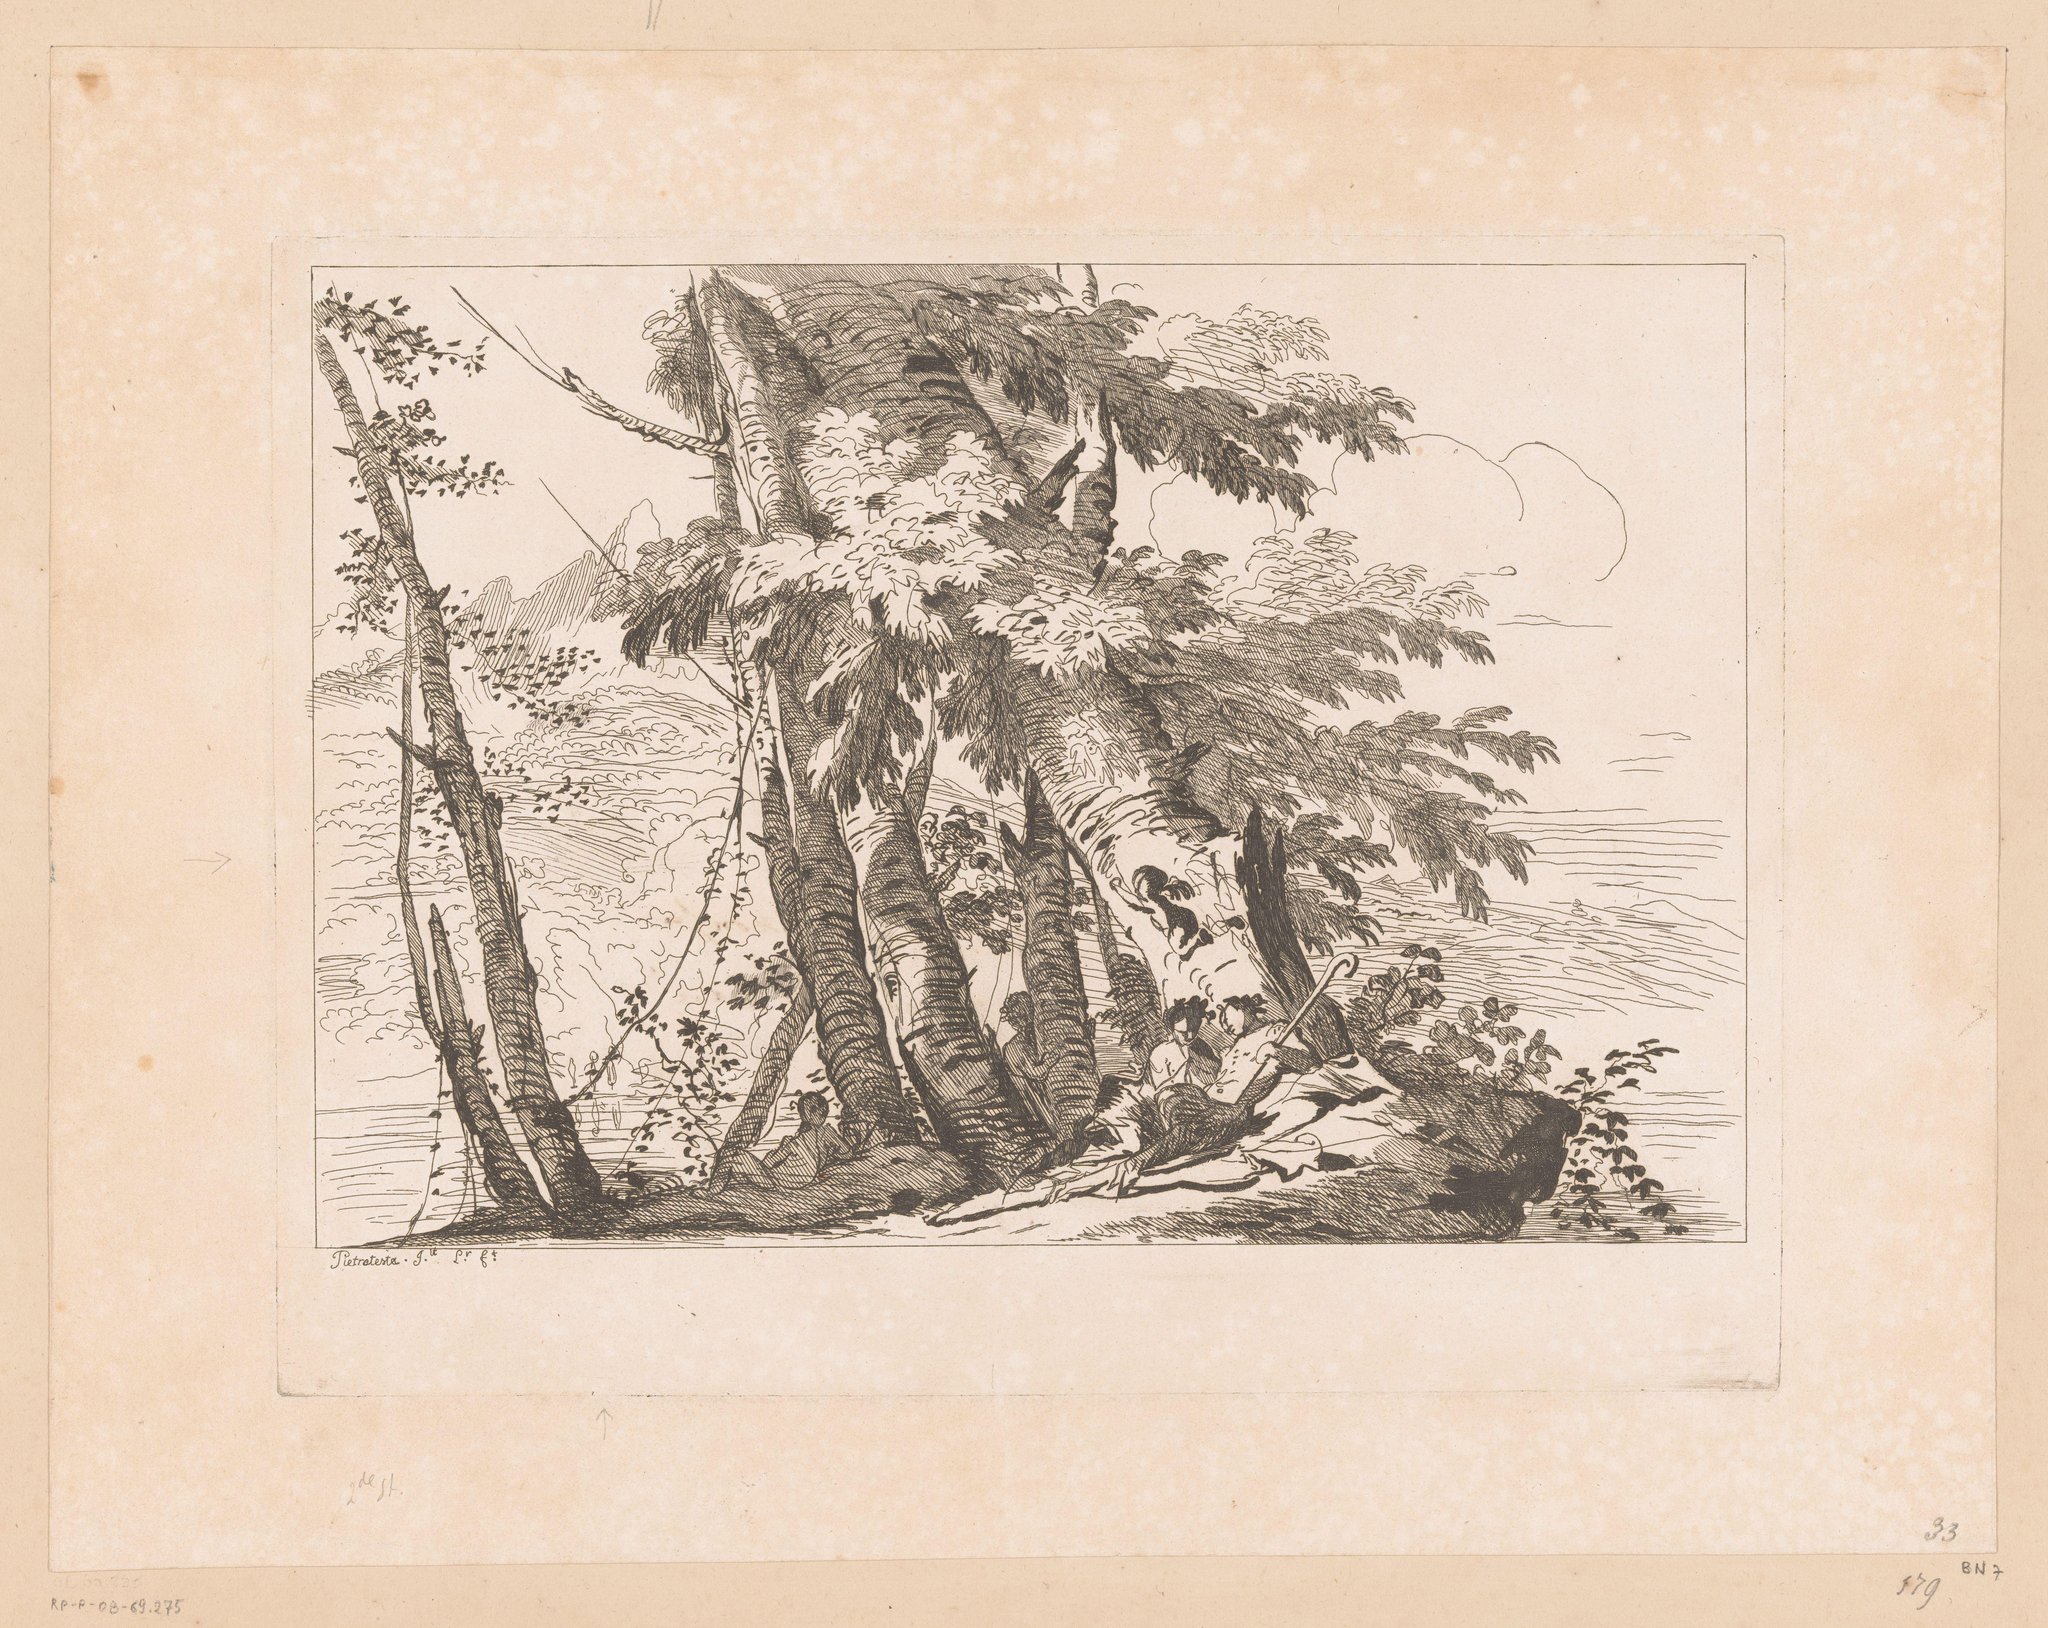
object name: print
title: Rustende figuren bij een groep bomen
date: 1758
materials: paper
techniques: etching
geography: france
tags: trees, satyr(s) (in general), resting - bb - out of doors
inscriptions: collector's mark: Lugt 240, inscription: ‘present van Monsieur Lampereur a paris’